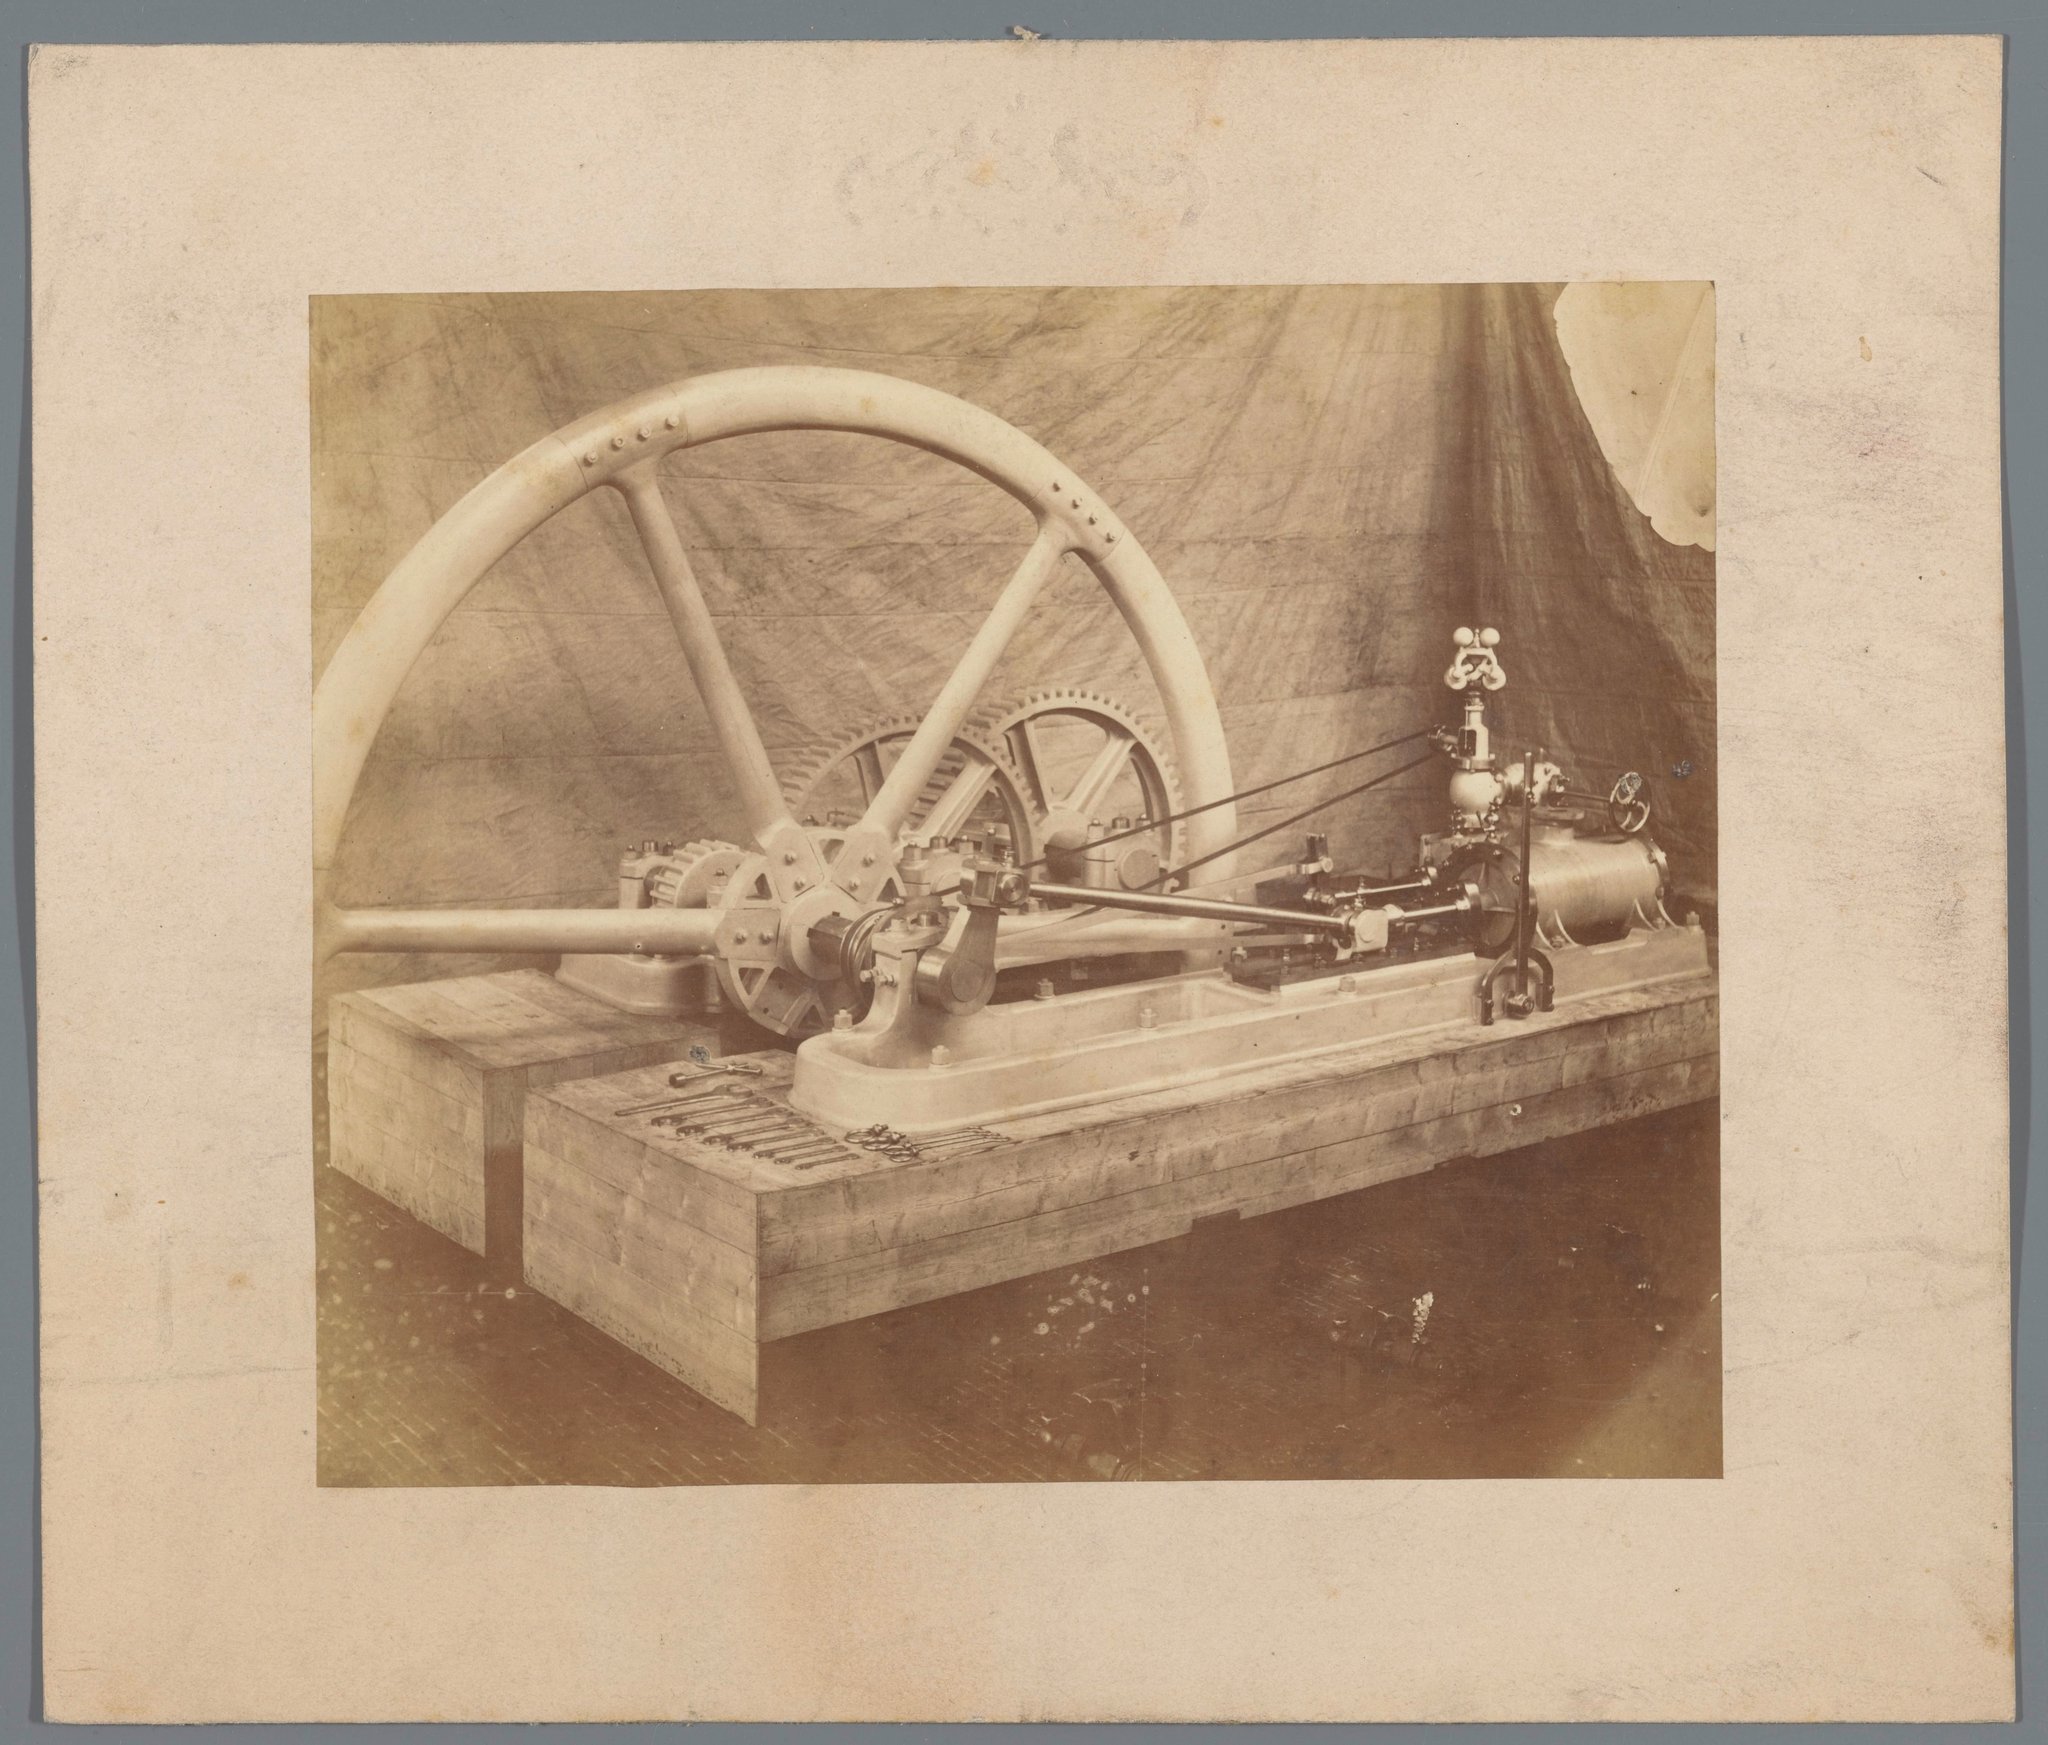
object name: photograph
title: Stoommachine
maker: Anonymous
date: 1875-1900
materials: cardboard, photographic support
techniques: albumen print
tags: (playing with) steam engine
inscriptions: annotation